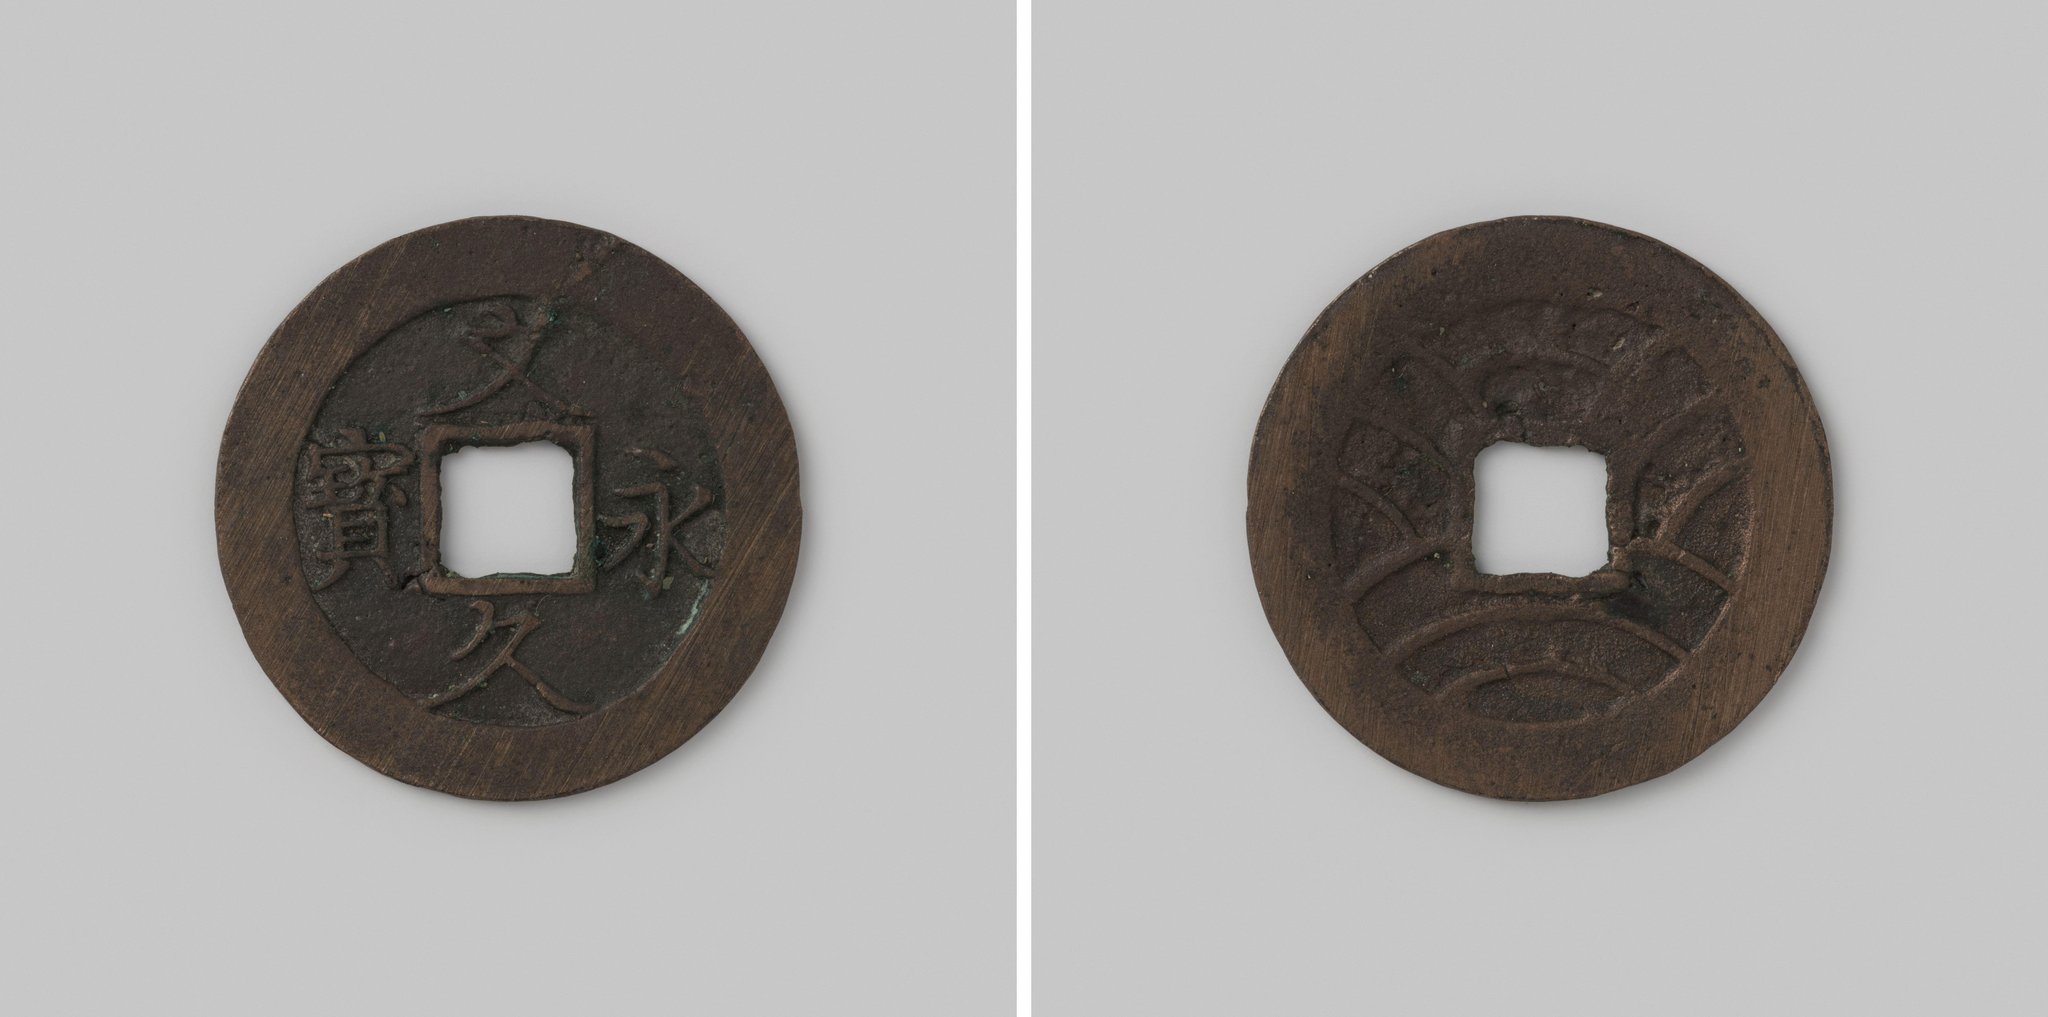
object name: mon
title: Bun sen van 1 mon uit het keizerrijk Japan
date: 1662-1672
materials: copper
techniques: casting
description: Koperen munt. Voorzijde: binnen brede gladde rand rondom vierkante uitsparing in het midden vier kruisgewijze geplaatste tekens met de betekenis: kanei tsuho [= kanei periode]. Keerzijde: binnen brede gladde rand bovenaan letterteken. [ bun = gegoten van het Boddha-beeld dat in 1662 bij een aardbeving gedeeltelijk werd vernietigd].